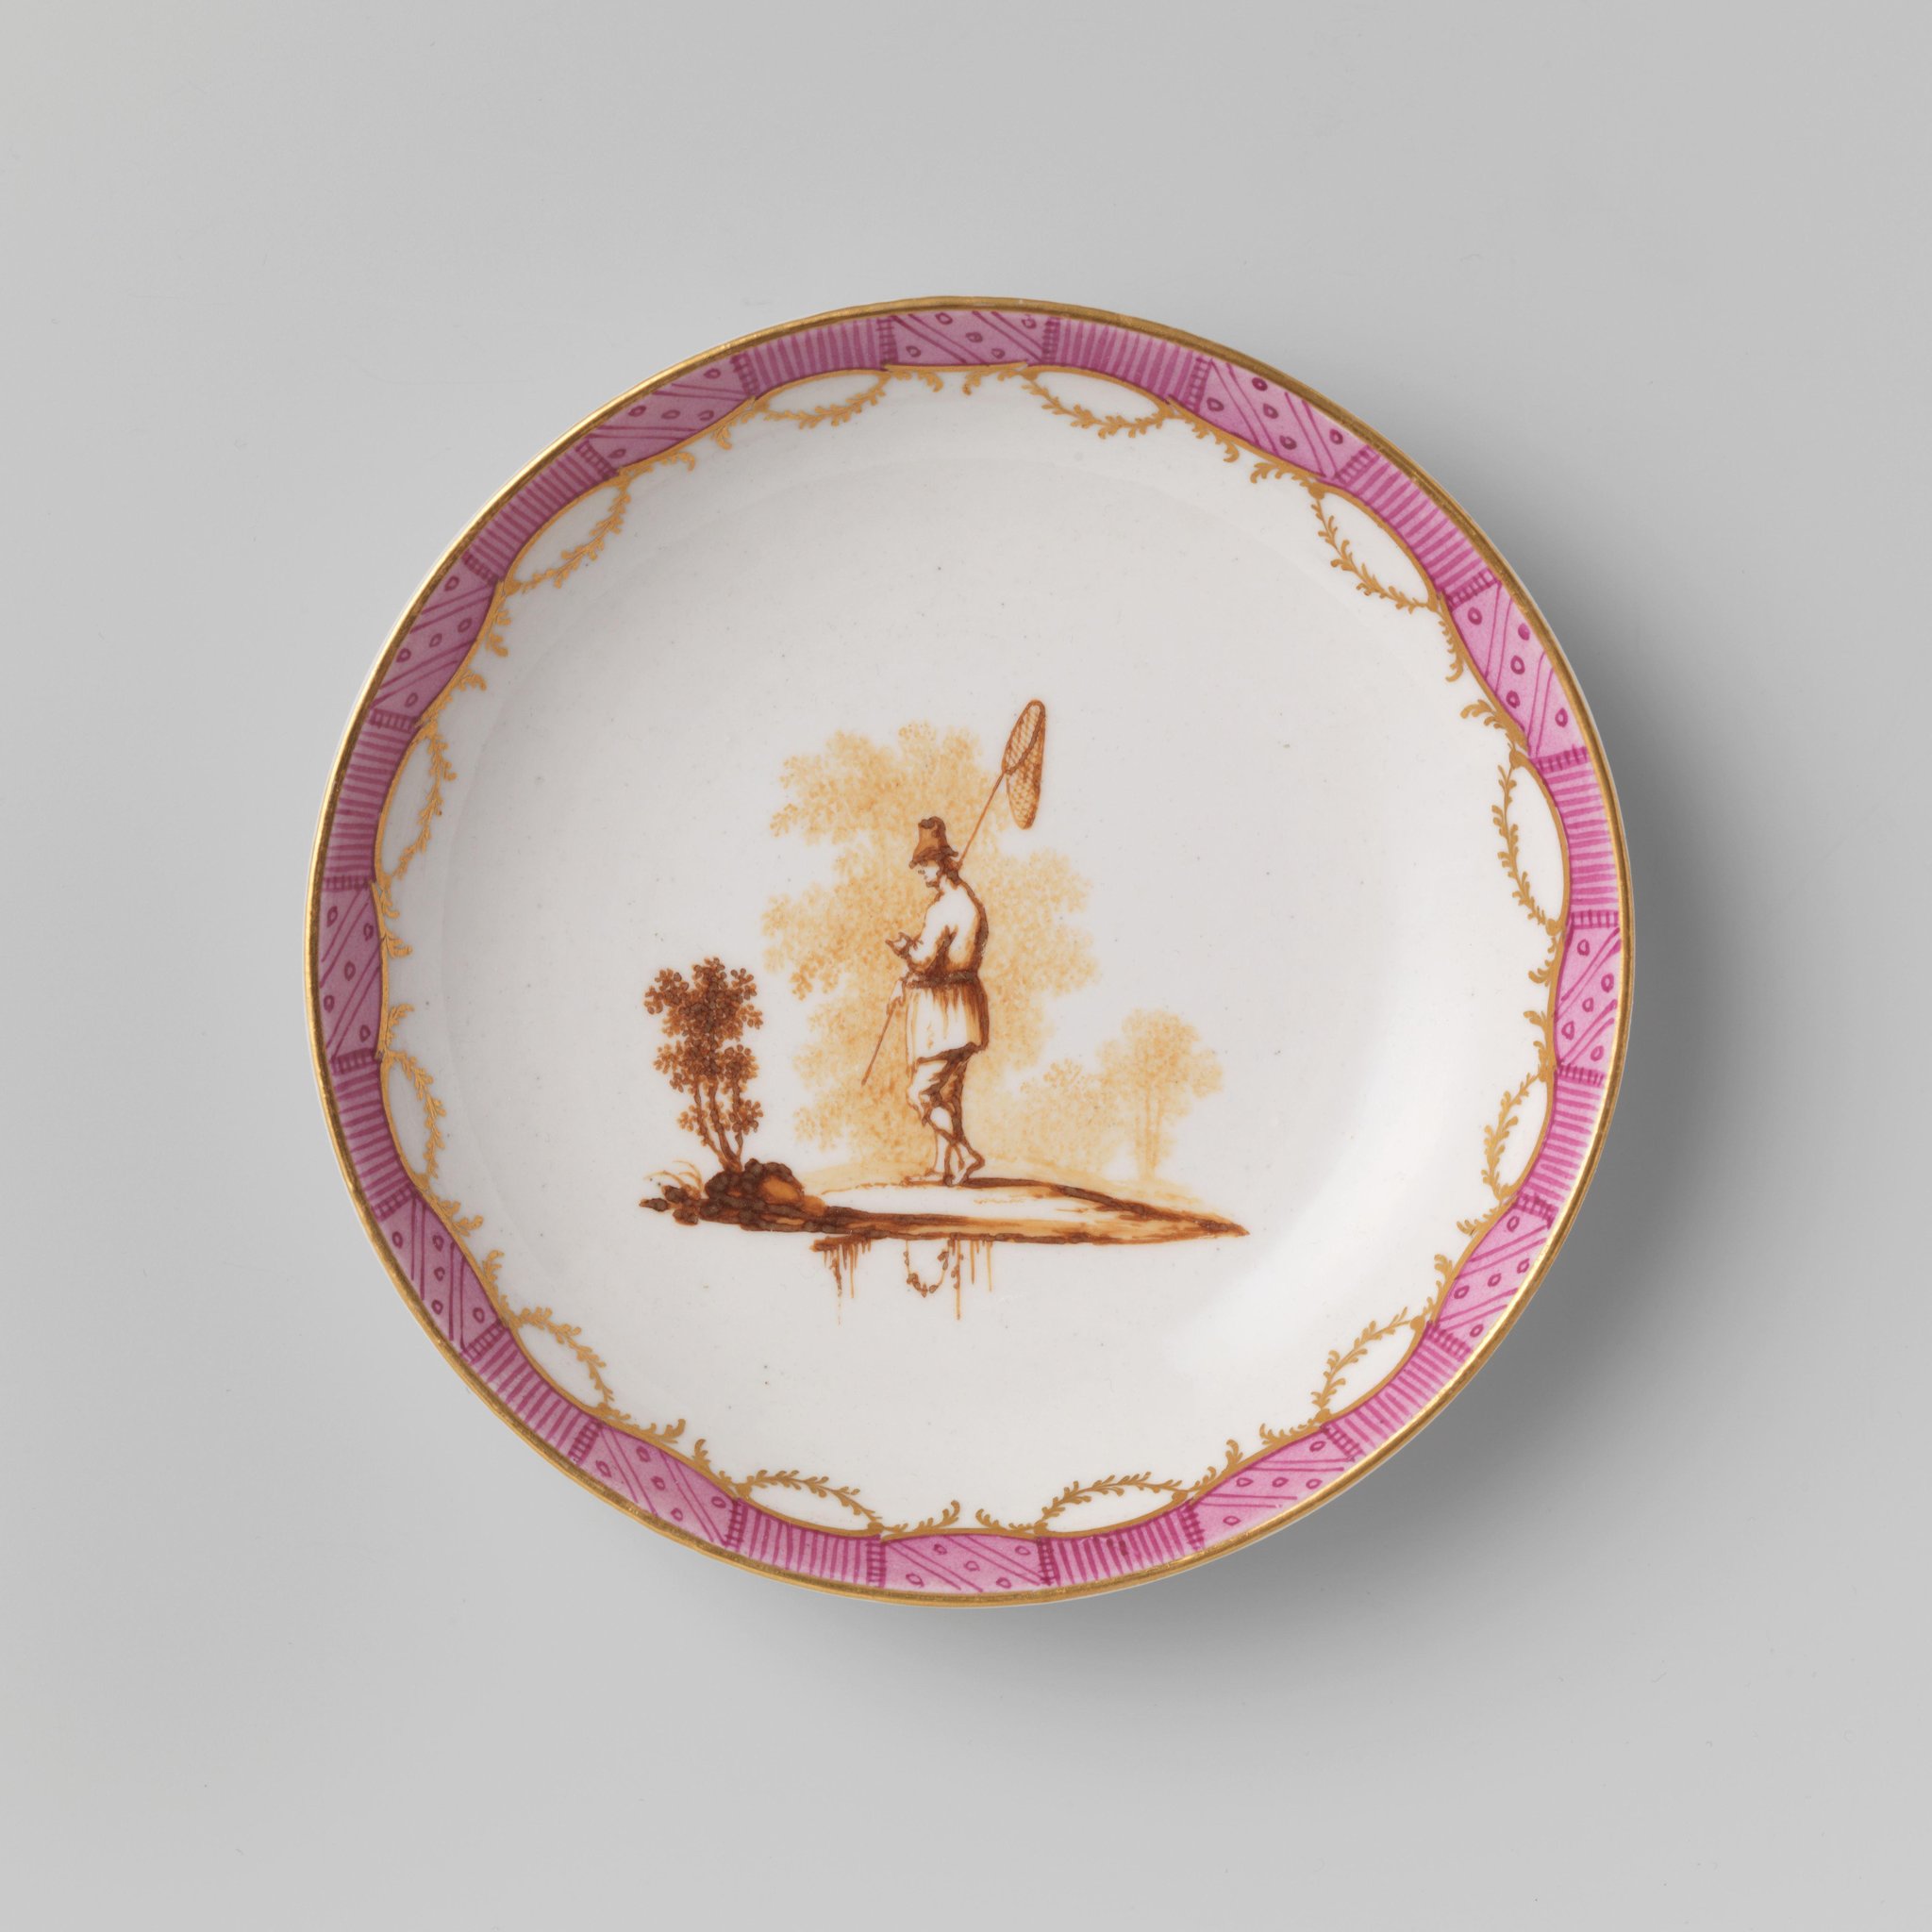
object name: platter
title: Schotel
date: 1774-1778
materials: porcelain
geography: loosdrecht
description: Schotel van porselein. Beschilderd in sepia met figuren in een landschap. Langs de rand een lila fries tussen gouden biezen.